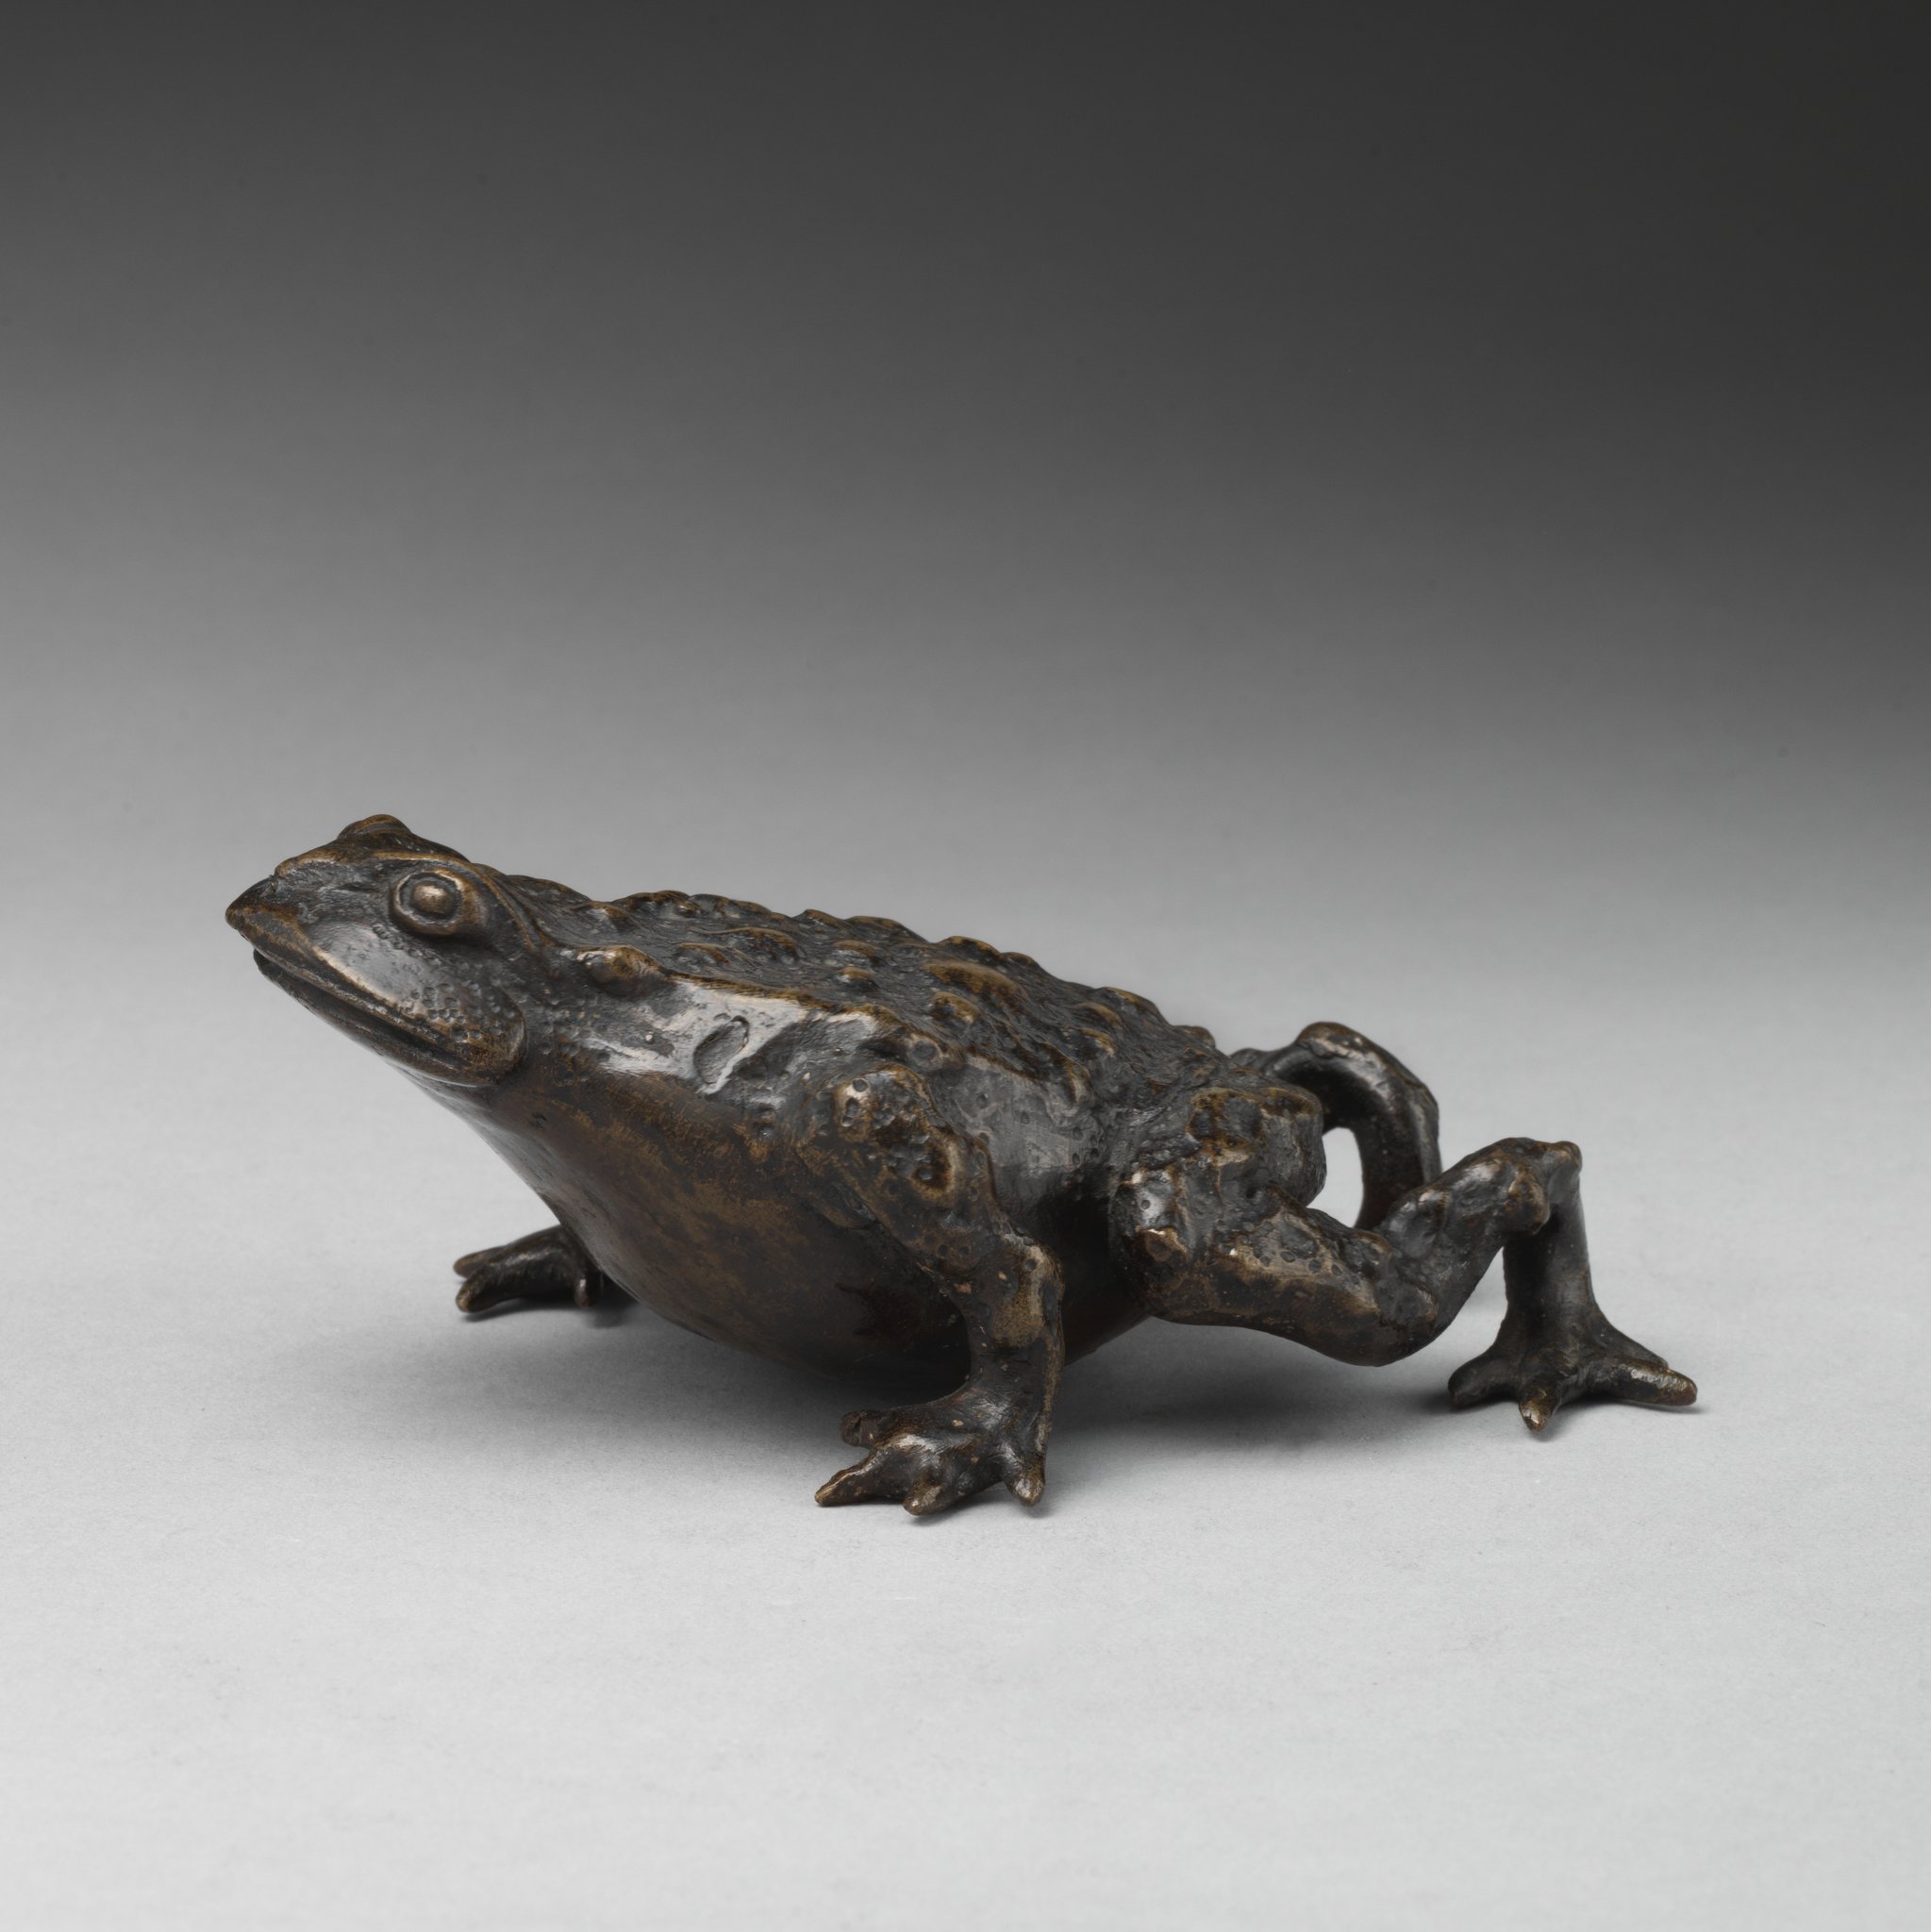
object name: statuette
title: Toad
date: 1501-1600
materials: bronze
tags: frogs